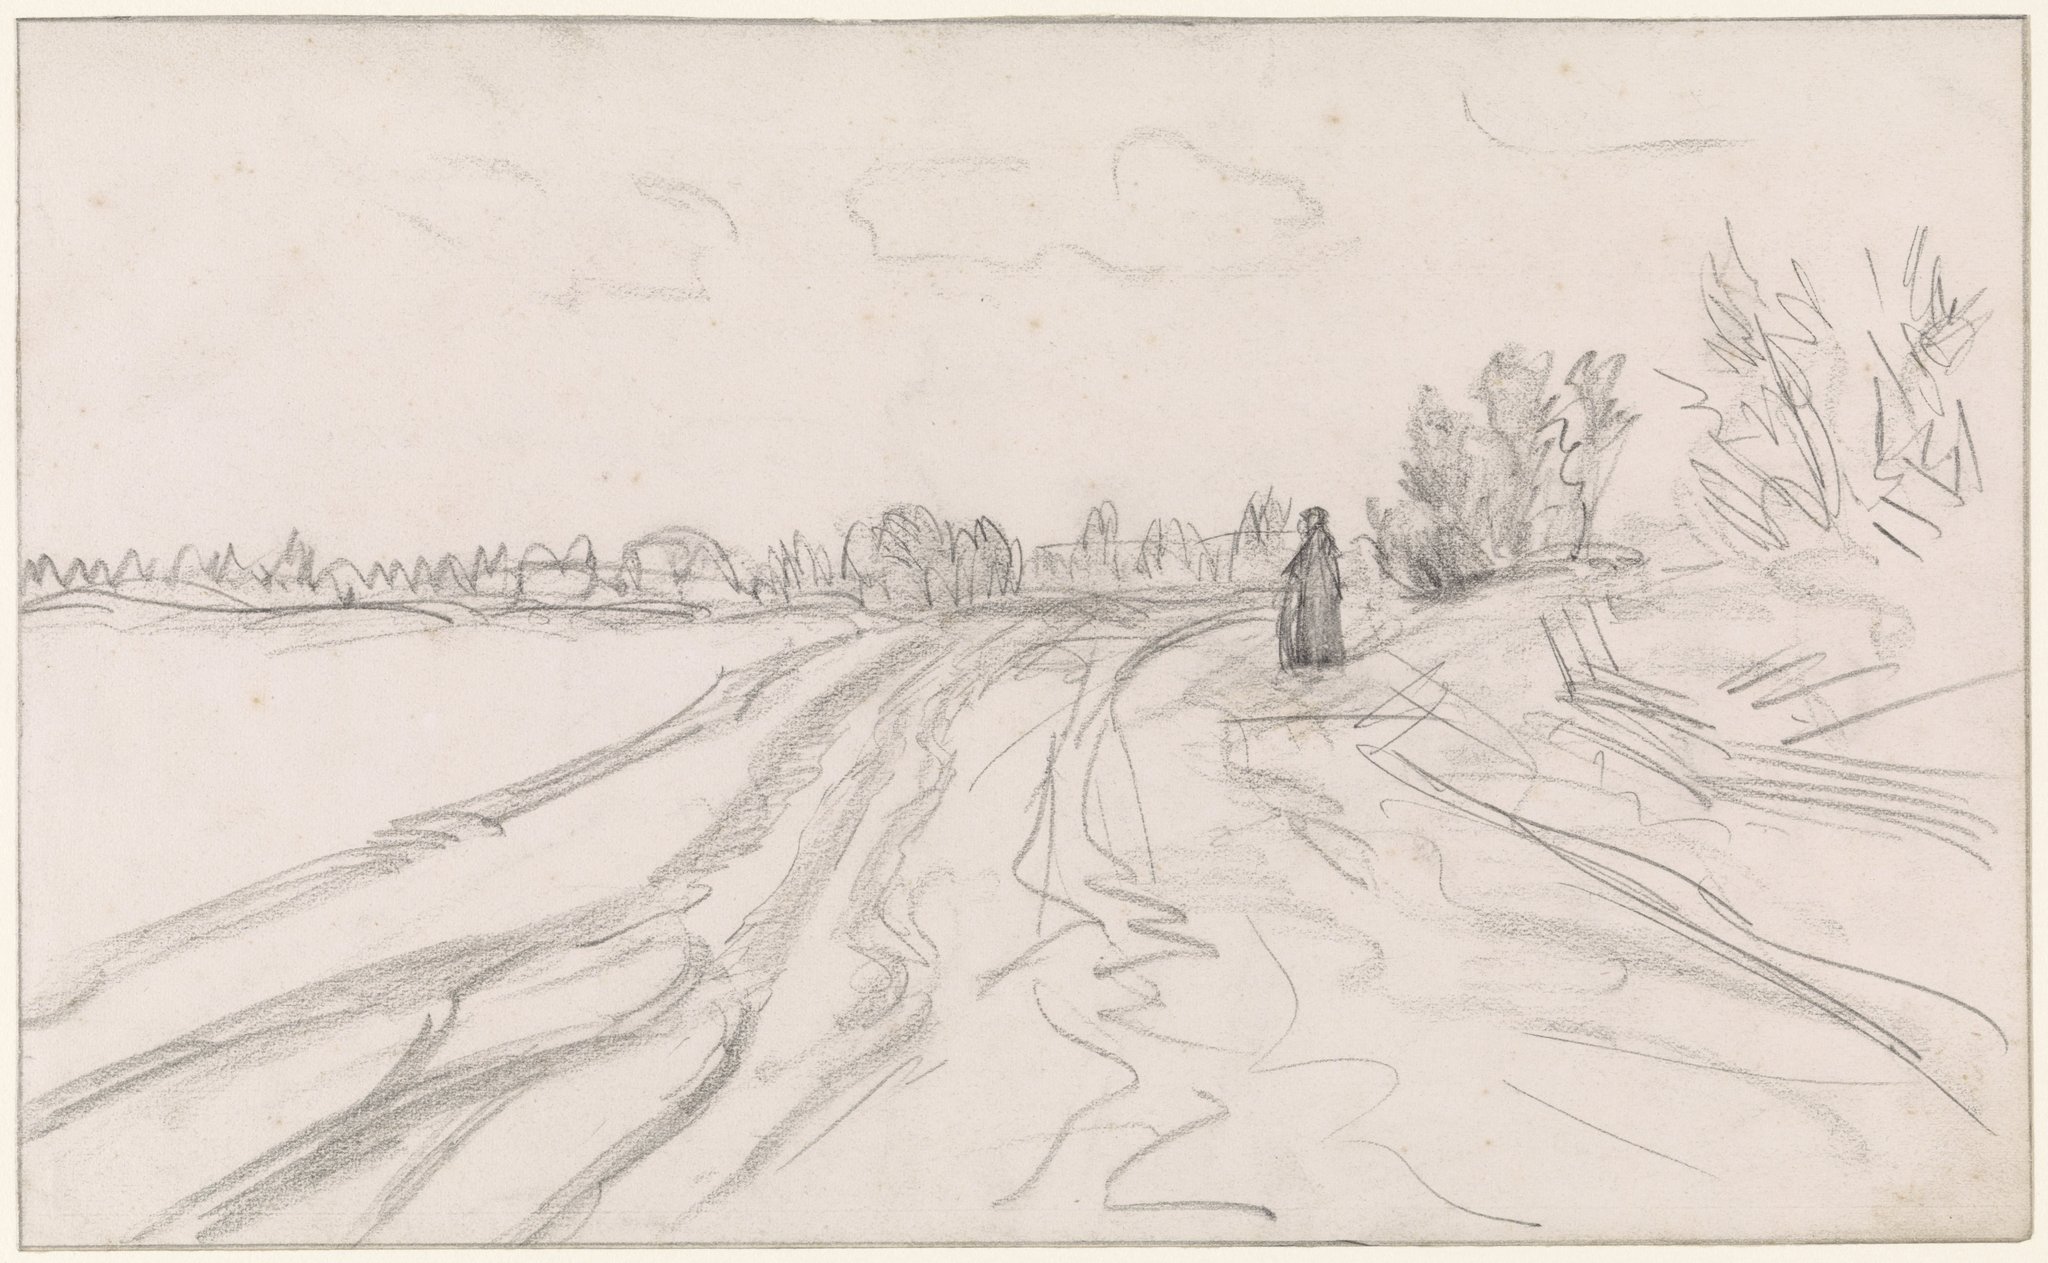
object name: drawing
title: Vrouw op landweg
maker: jan van essen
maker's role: draughtsman, print maker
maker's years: 1854-1936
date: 1864-1936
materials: chalk, paper